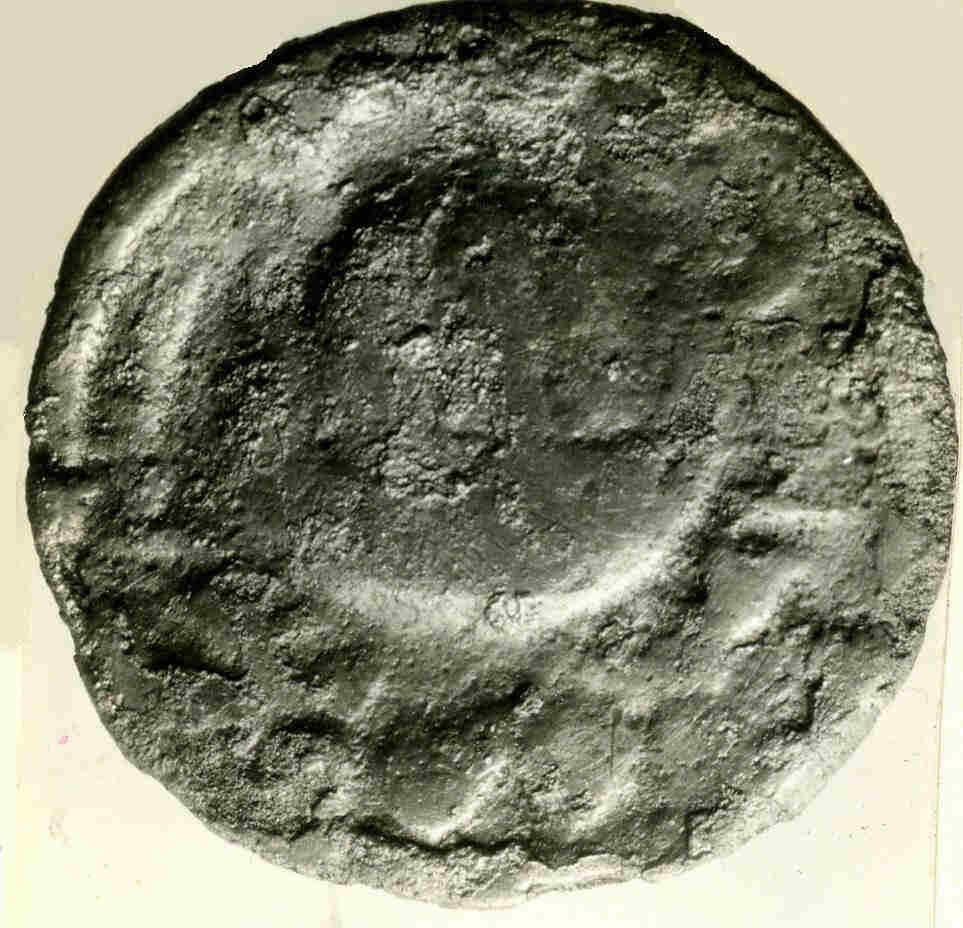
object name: coin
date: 1197-1219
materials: copper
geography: iran